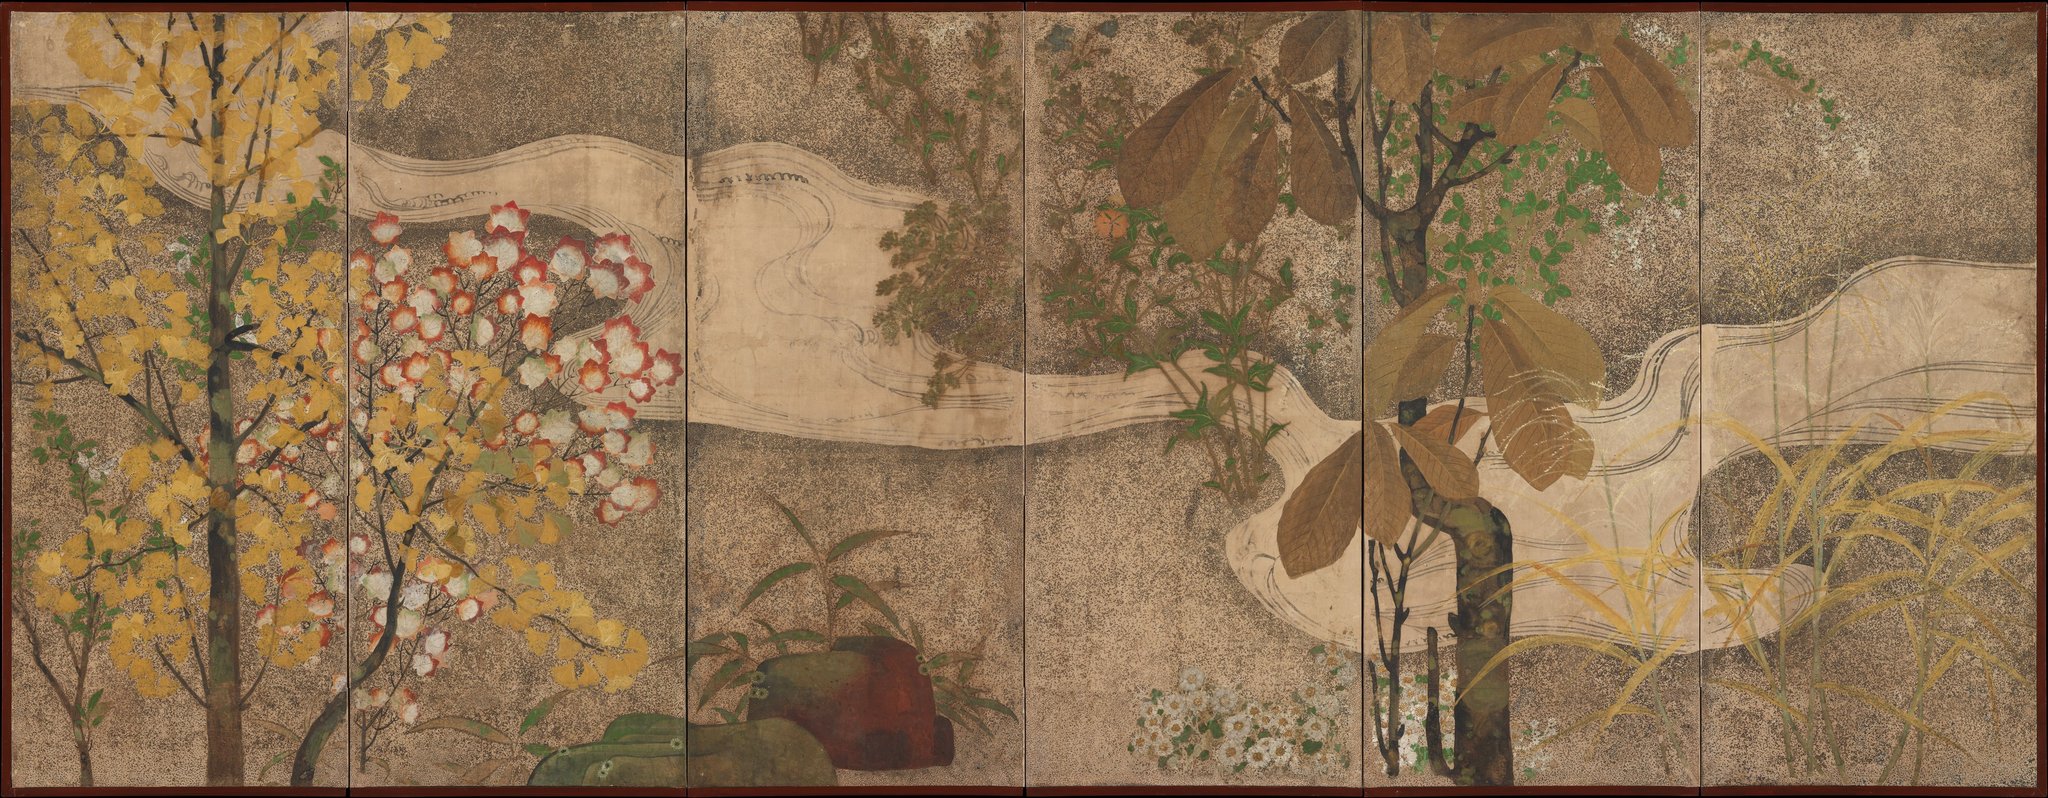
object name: screen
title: Autumn Trees and Grasses by a Stream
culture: japanese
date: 1667-1733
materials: gold, ink, panel, paper, silver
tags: trees,autumn,streams